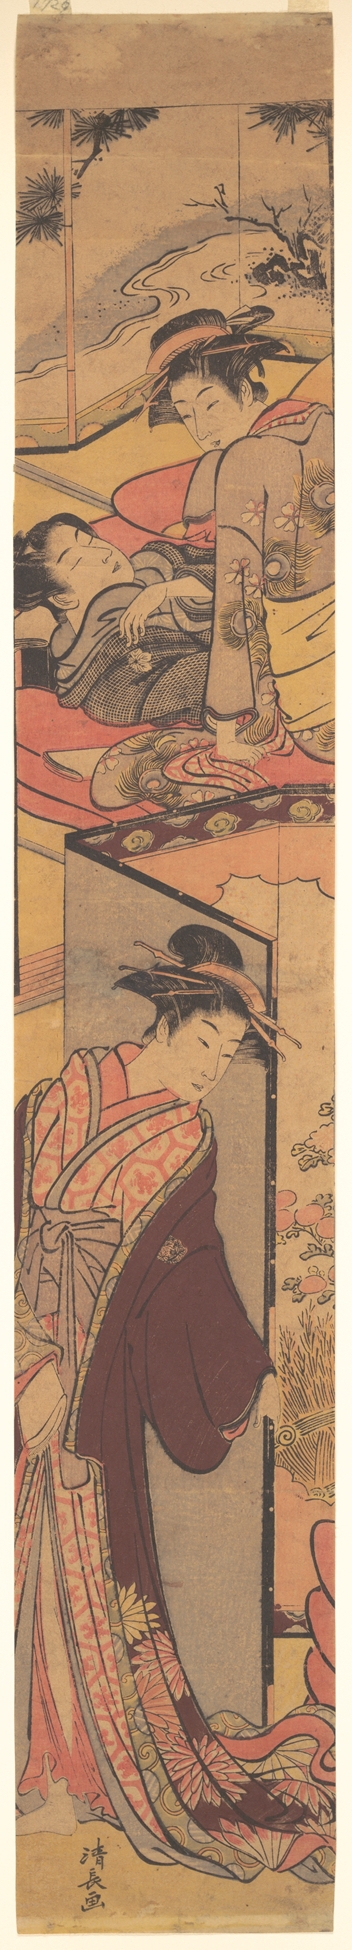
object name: print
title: In a Pleasure House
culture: japanese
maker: torii kiyonaga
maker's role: artist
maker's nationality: japanese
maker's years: 1752-1815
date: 1767-1800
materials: ink, paper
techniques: woodblock print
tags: men,women